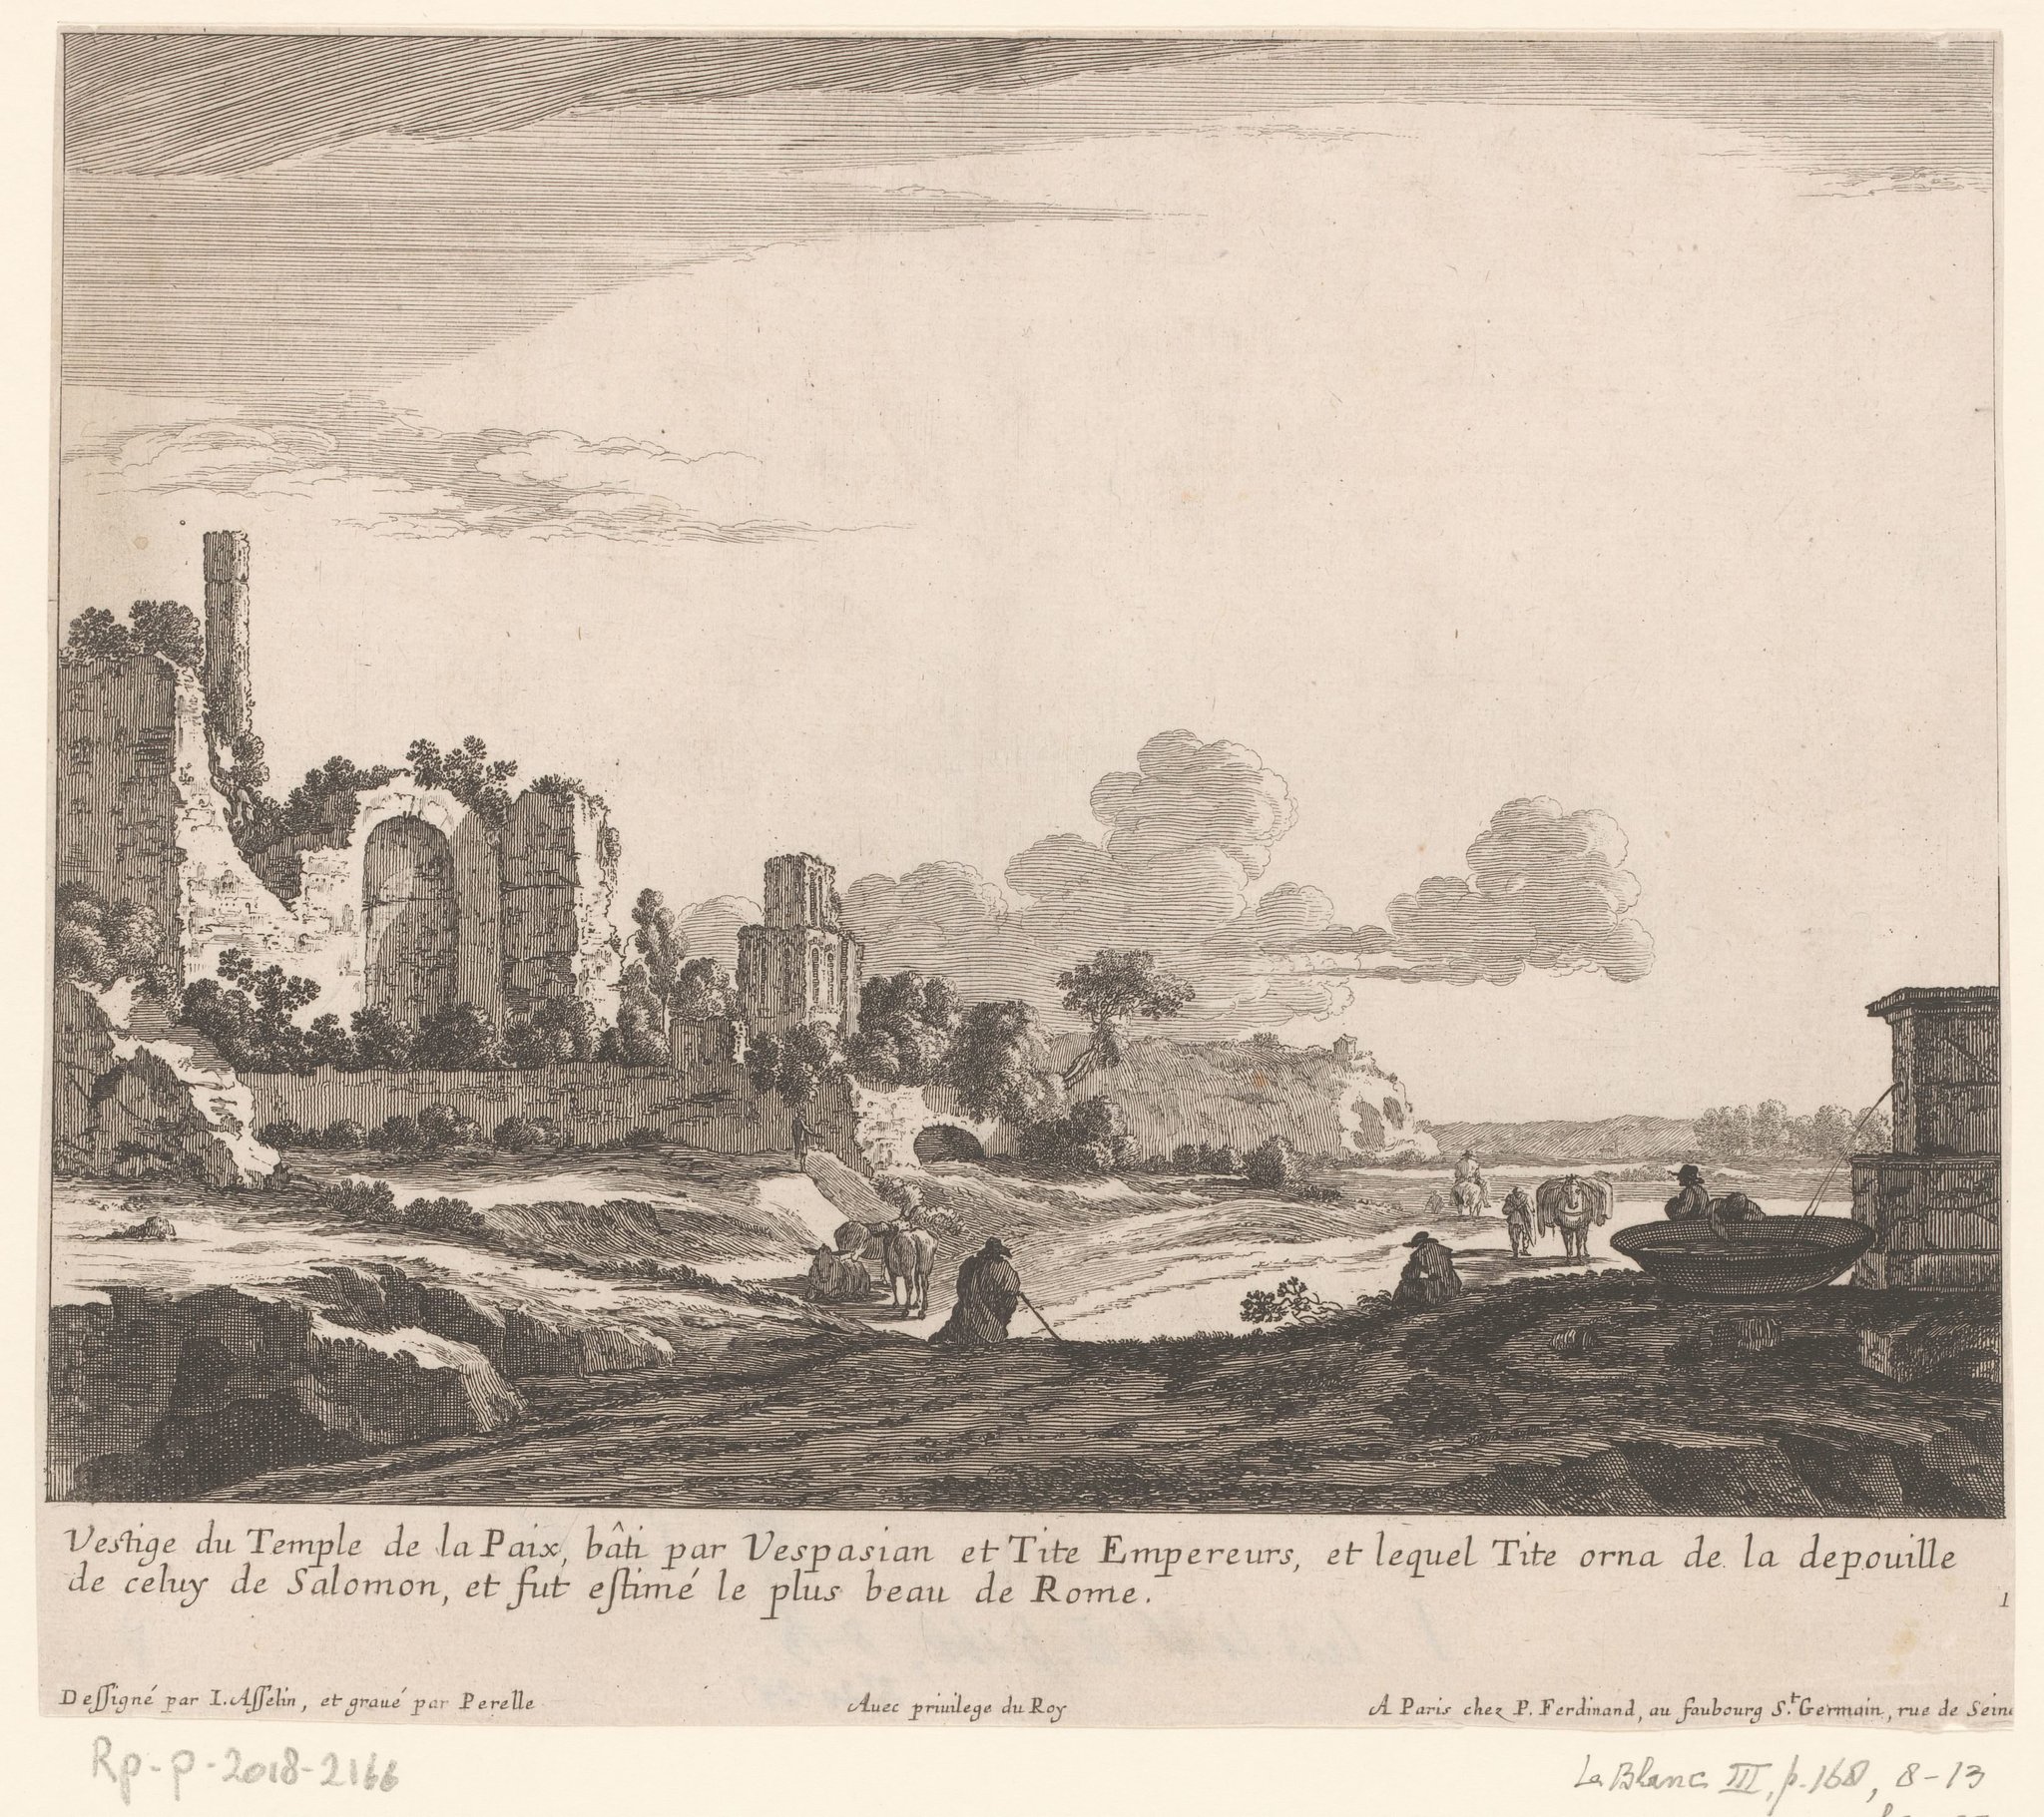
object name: print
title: Gezicht op de ruïnes van de Vredestempel, te Rome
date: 1641-1655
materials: paper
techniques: engraving, etching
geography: paris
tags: landscape with ruins, temple, shrine ~ roman religion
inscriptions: collector's mark: Lugt 240